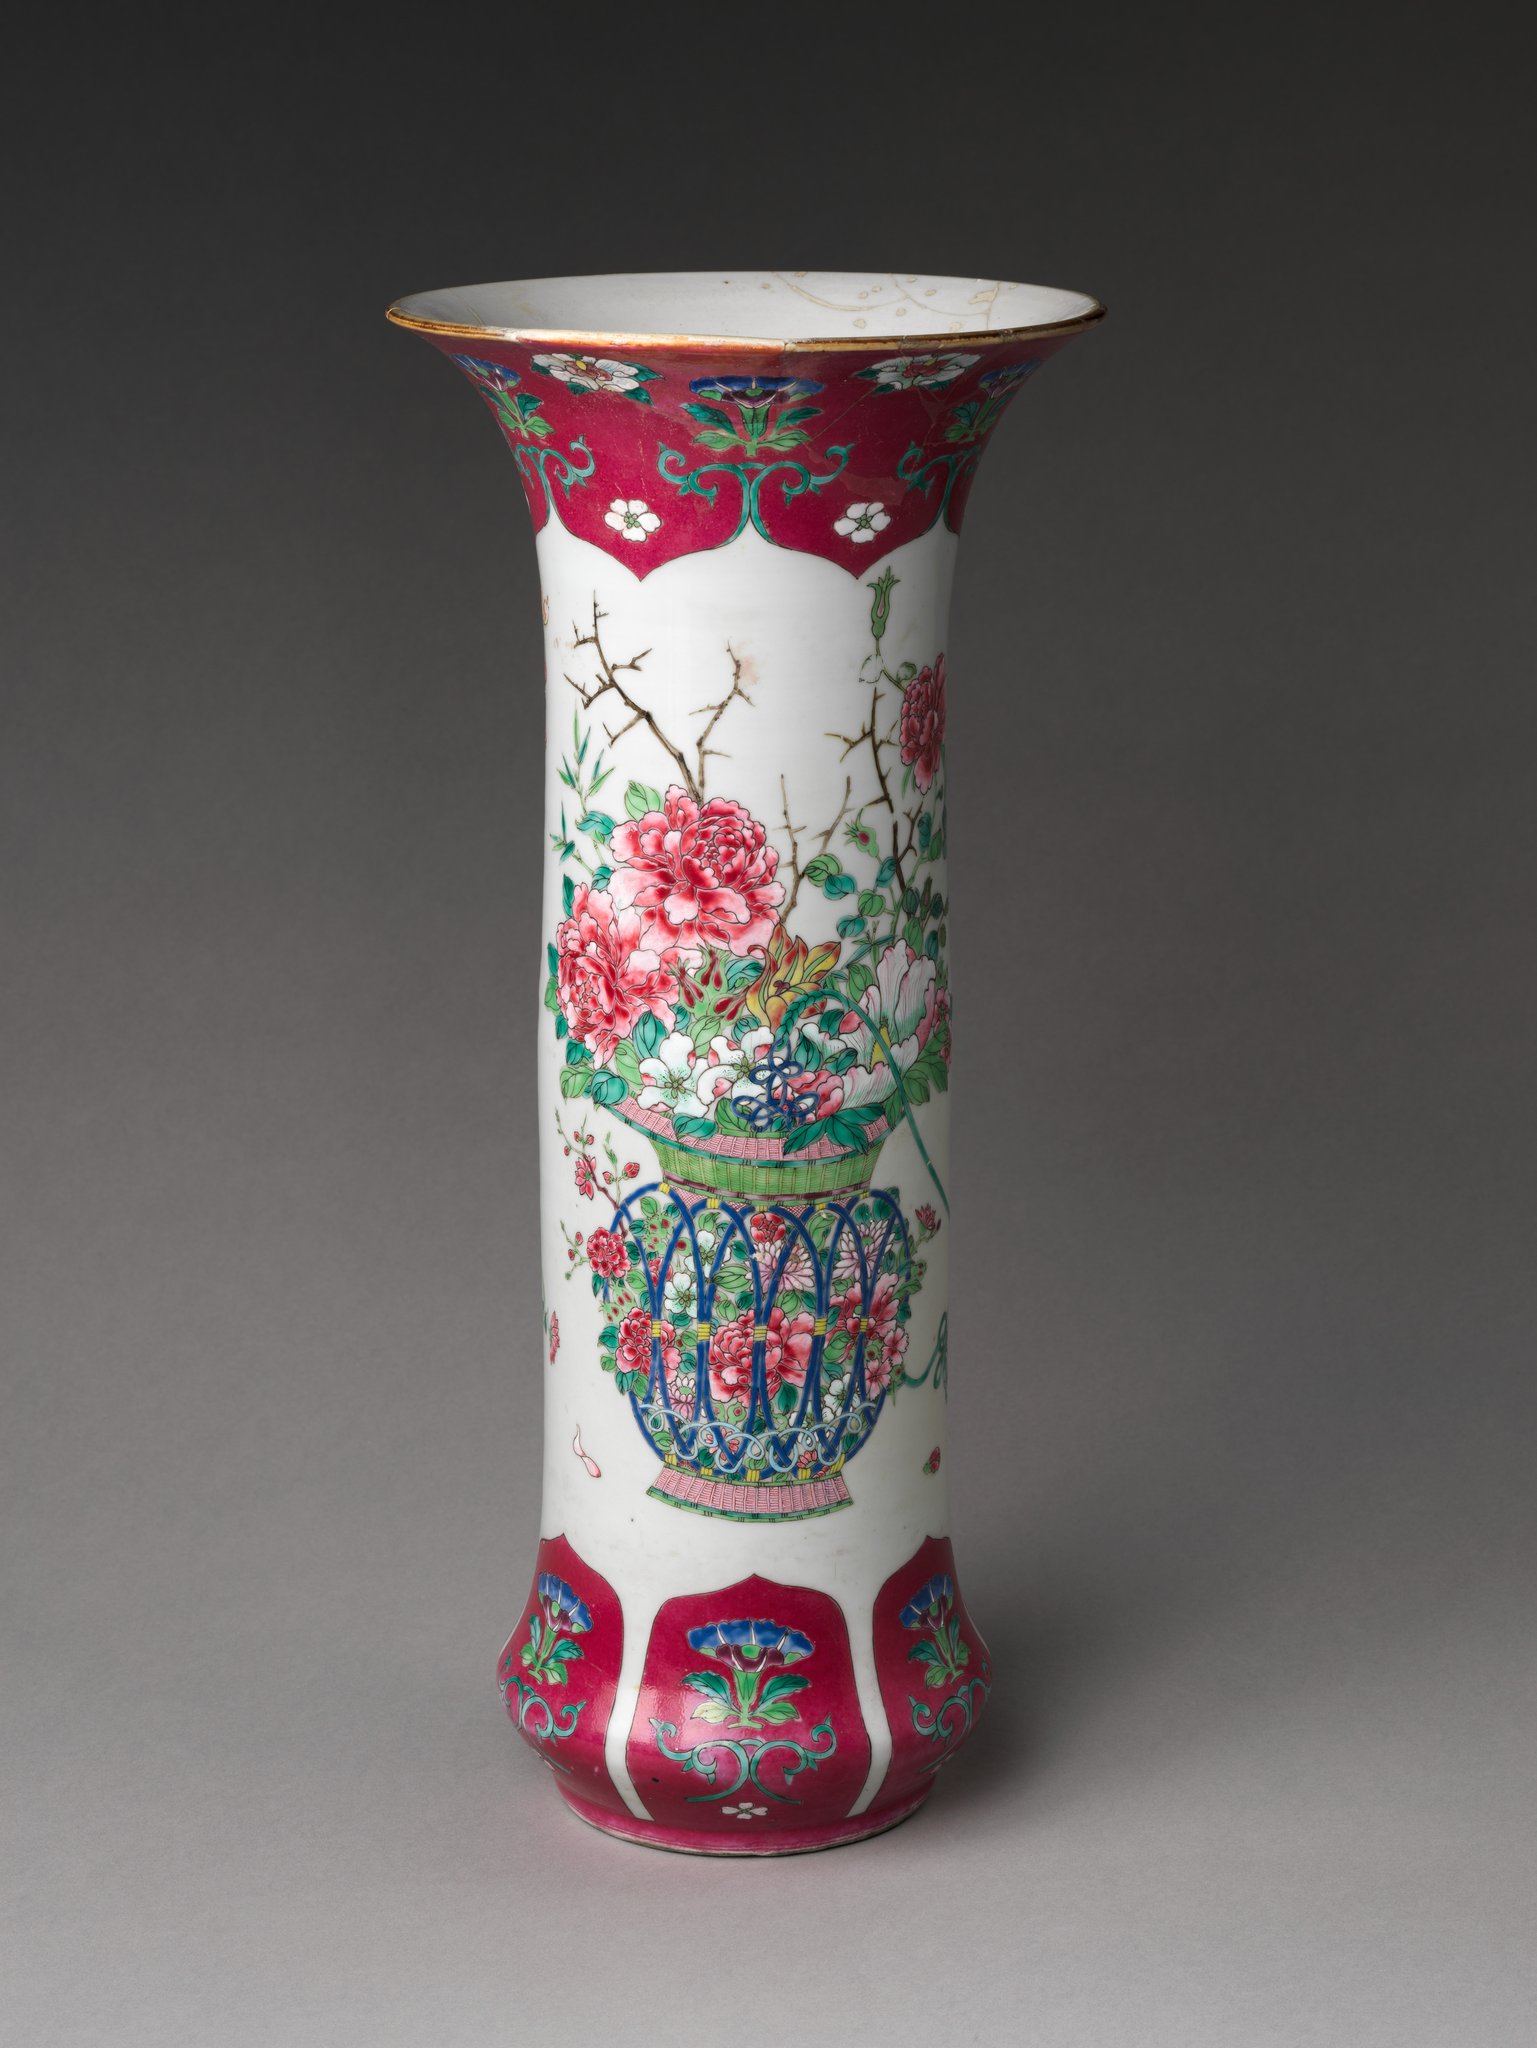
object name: vase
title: Vase with Basket of Auspicious Flowers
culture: chinese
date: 1701-1800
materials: enamel, glaze, porcelain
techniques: painting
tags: flowers